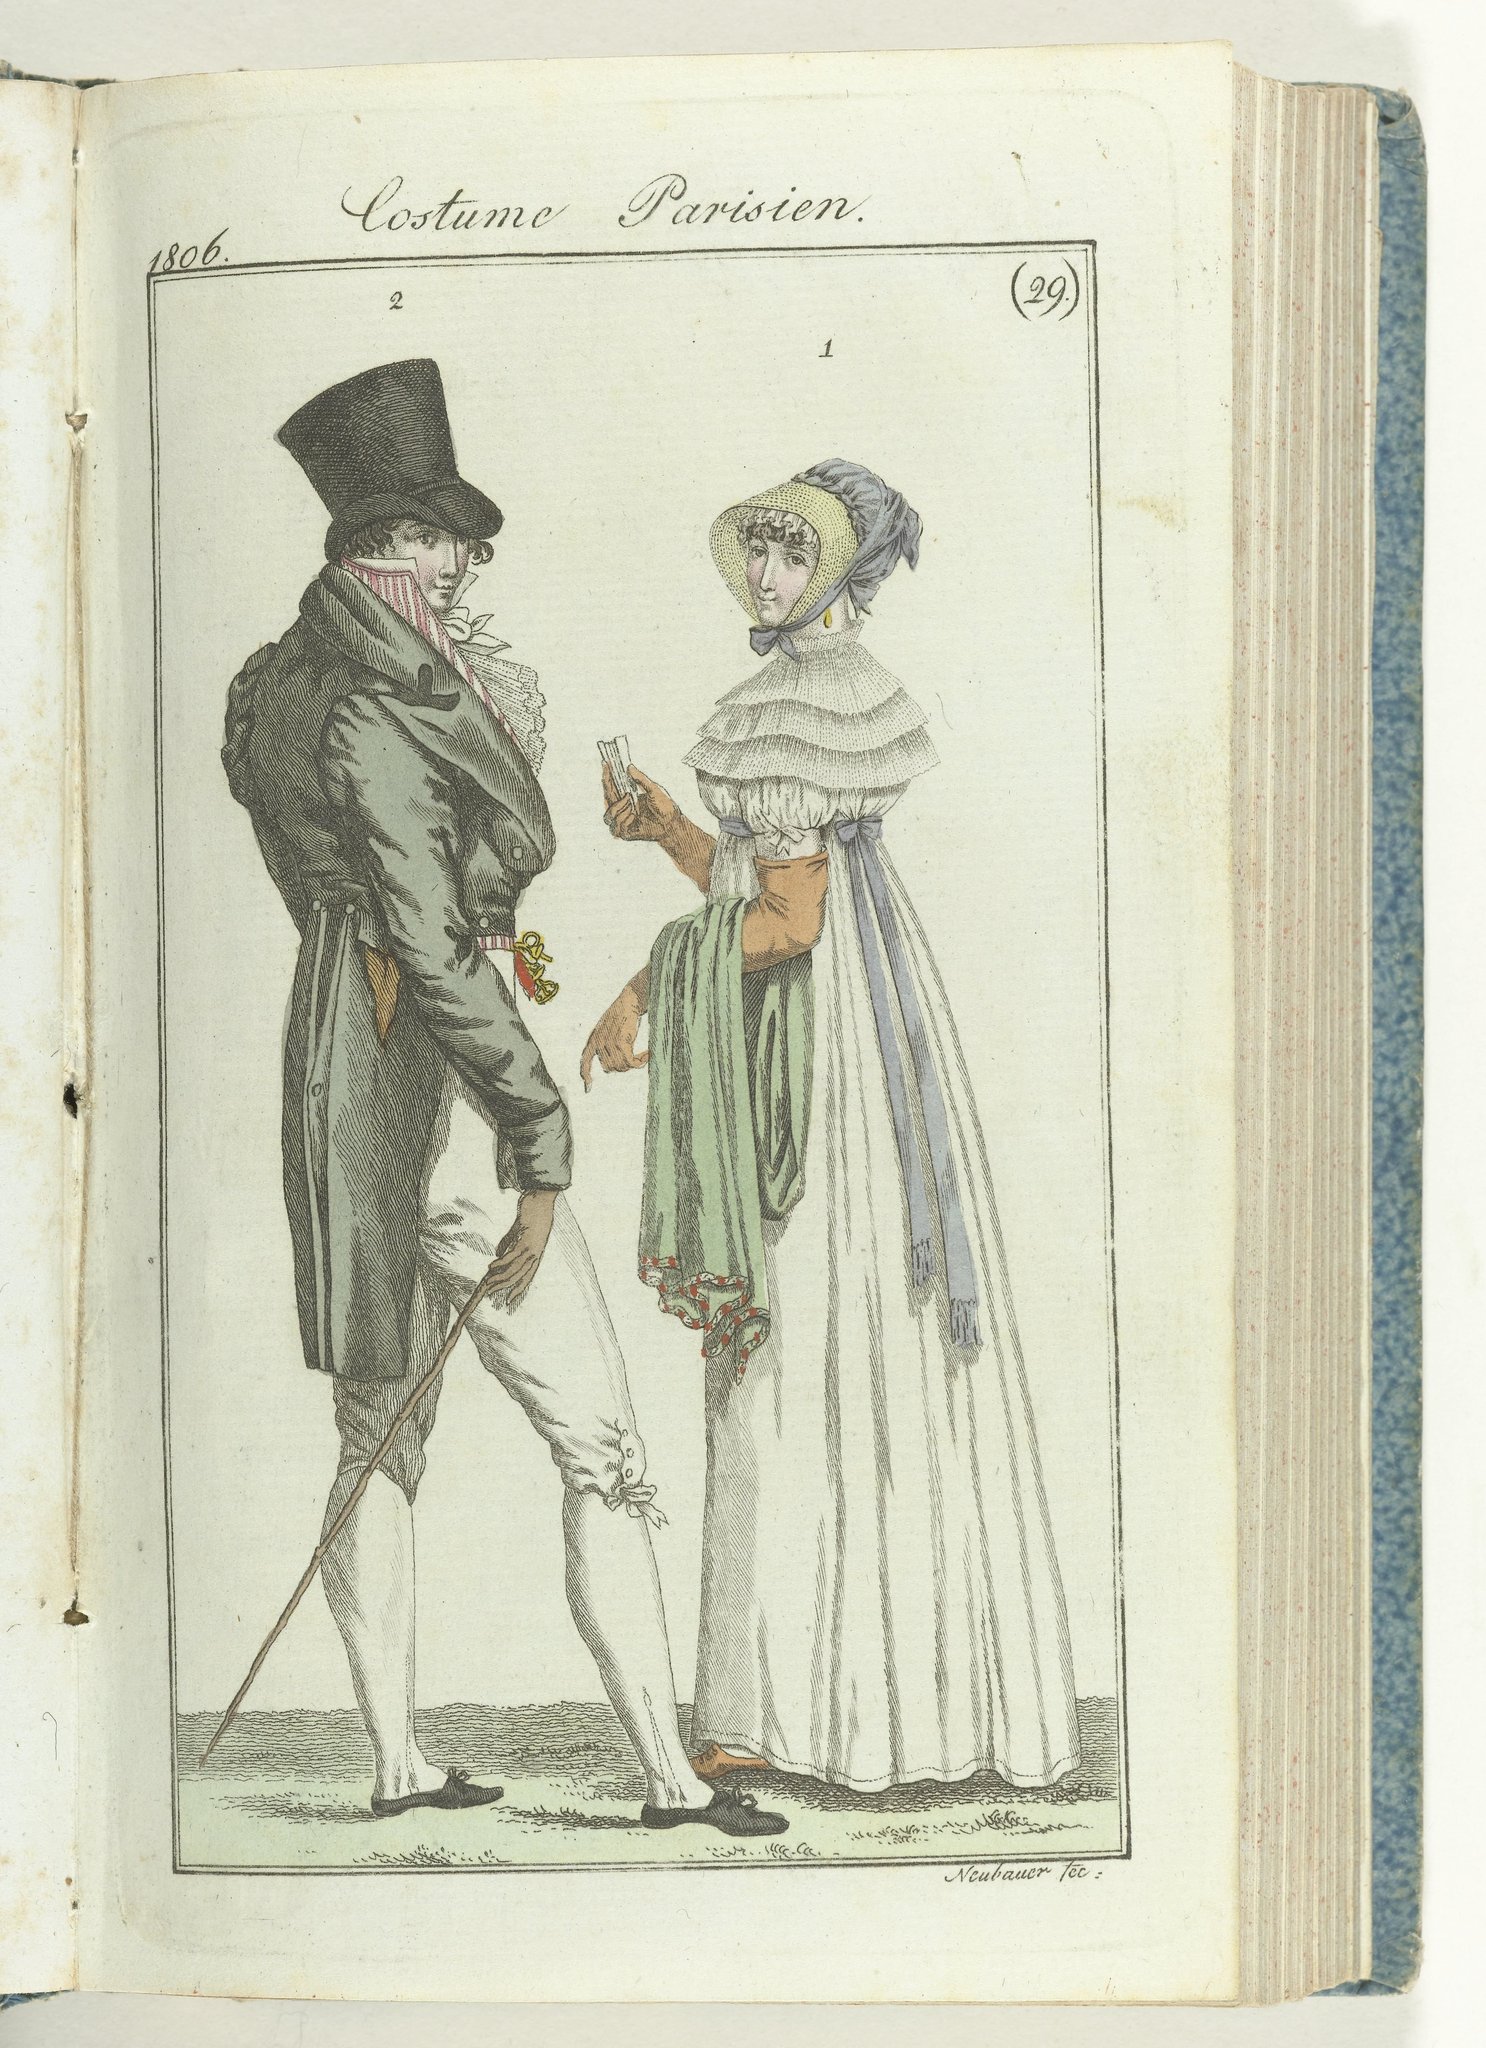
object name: fashion print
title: Journal des Dames et des Modes, editie Frankfurt 14 juillet 1806, Costume Parisien (29)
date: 1806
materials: paper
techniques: engraving, hand coloring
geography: frankfurt am main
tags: clothing for the upper part of the body (vest) (+ men's clothes), clothing for the upper part of the body (shawl) (+ women's clothes), clothing for the upper part of the body (pelerine) (+ women's clothes), coat (+ men's clothes), fashion plates, head-gear: hat (+ women's clothes), dress, gown (+ women's clothes), shoes, sandals (+ men's clothes), trousers, breeches, etc. (breeches) (+ men's clothes), stockings, socks (+ men's clothes), walking-stick, staff, cane (+ men's clothes), belt, girdle, waistband (+ women's clothes)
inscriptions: title: ‘Costume Parisien.’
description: De begeleidende tekst (p. 84) vermeldt: Fig. 1: 'Chapeau de négligé'. Japon van witte mousseline. Korte pofmouwen. Ceintuur van paars lint. Geplisseerde pélerine. Sjaal van groene zijde. Handschoenen van leer. Open schoenen in chamois. Fig. 2: Hoge hoed. Frak van zeegroene stof, met smalle taille en brede revers. Vest van gestreepte roze stof. Jabot met grote plooien. Culotte van witte kasjmier. Witte zijden kousen. De prent maakt deel uit van het modetijdschrift Journal des Dames et des Modes, uitgegeven in Frankfurt als kopie van de Franse editie van Pierre de la Mésangère, (1798-1848).